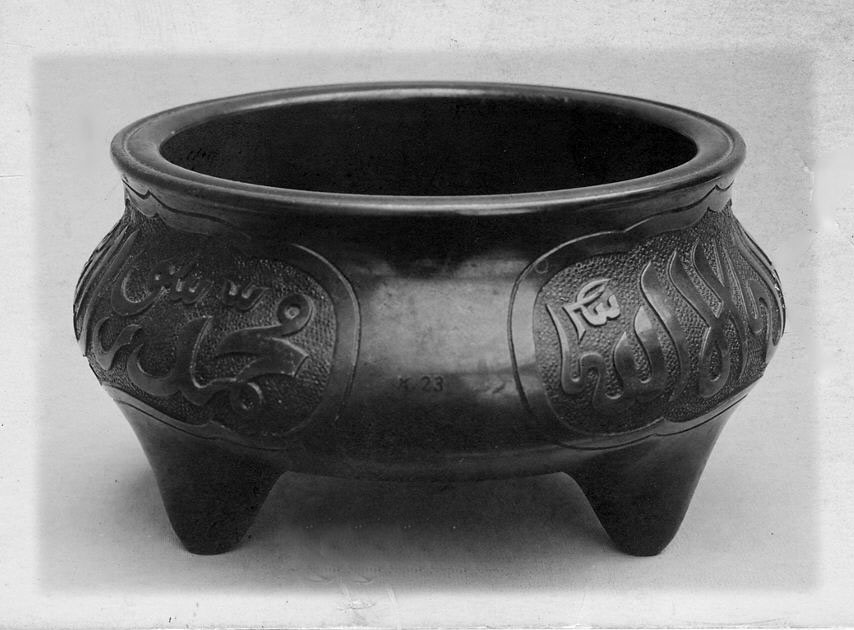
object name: incense burner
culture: chinese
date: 1667-1733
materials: brass